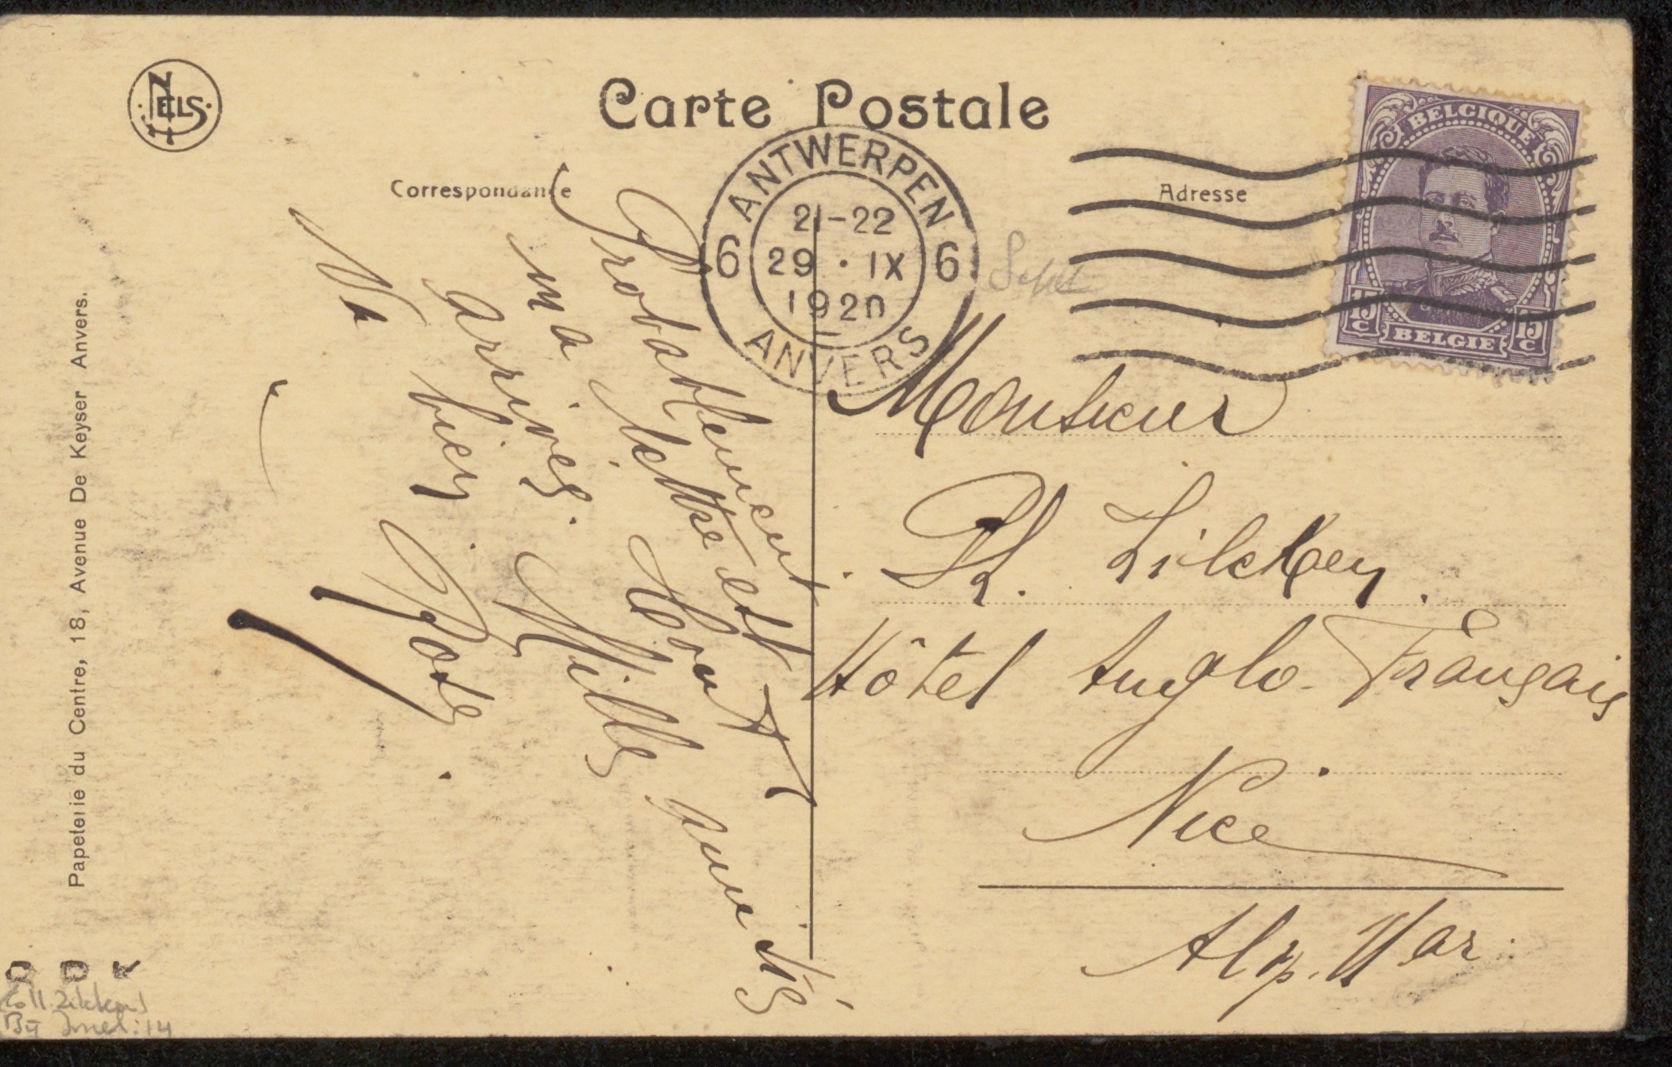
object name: ansichtkaart, prentbriefkaart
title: Prentbriefkaart aan Philip Zilcken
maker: rose imel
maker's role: draughtsman, painter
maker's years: 1901-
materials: cardboard, ink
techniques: photograph, pen, writing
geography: antwerp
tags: painter, draughtsman, philip zilcken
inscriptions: collector's mark: ‘RPK’